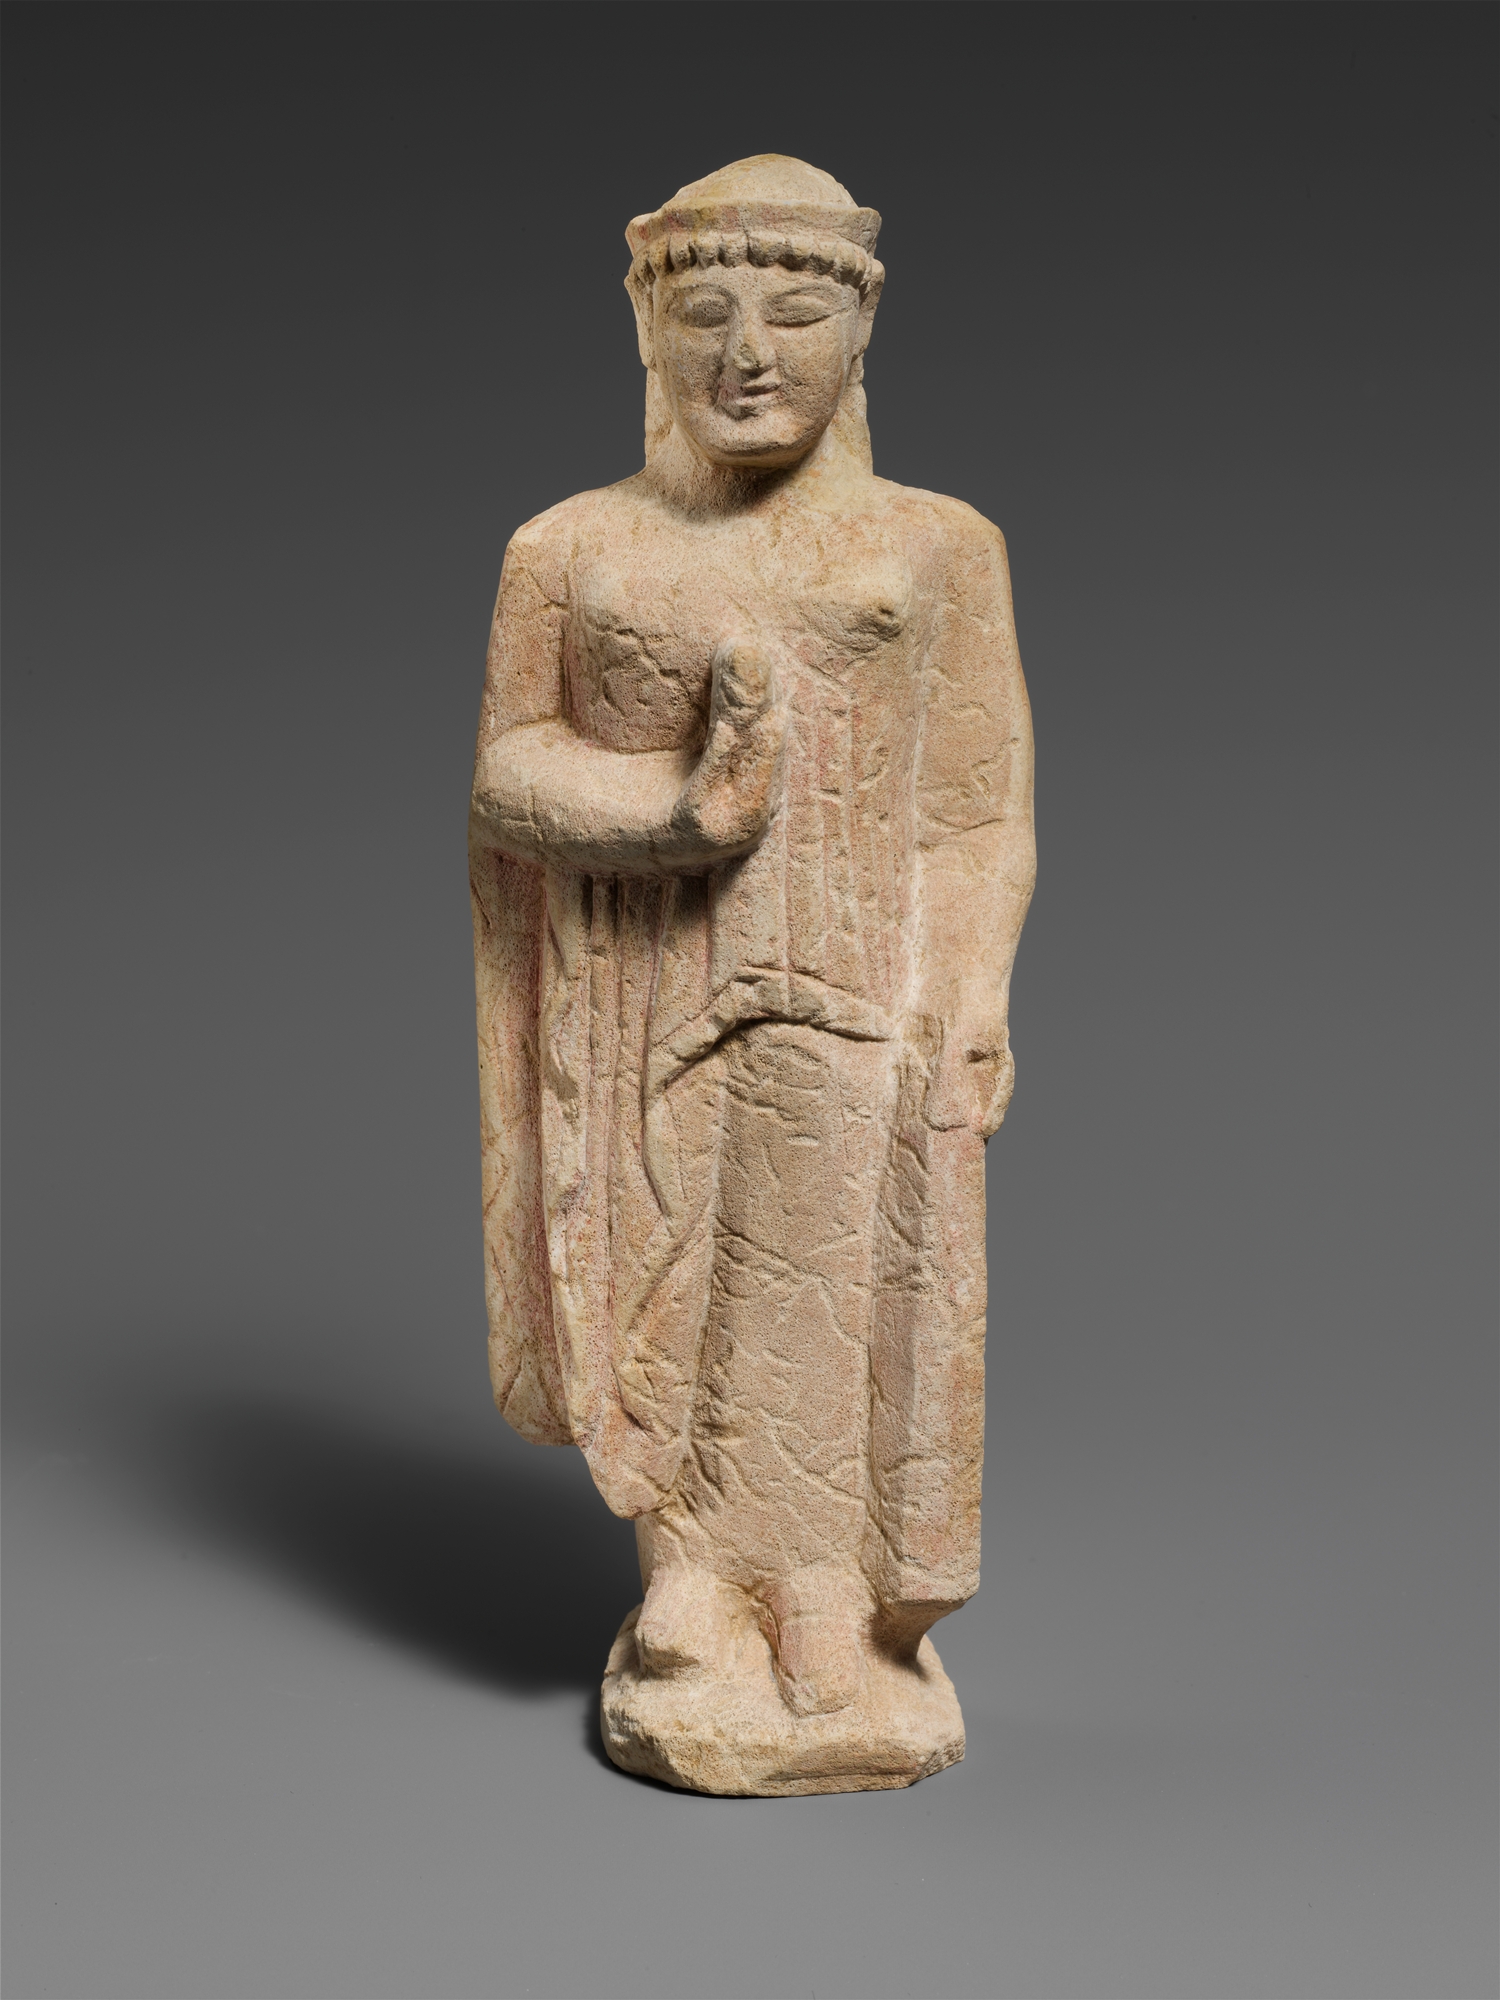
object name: statuette of a woman votary holding flower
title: Limestone woman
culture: cypriot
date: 600-501 BCE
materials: limestone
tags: women